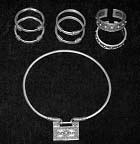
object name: jewelry set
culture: chinese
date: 1900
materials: silver